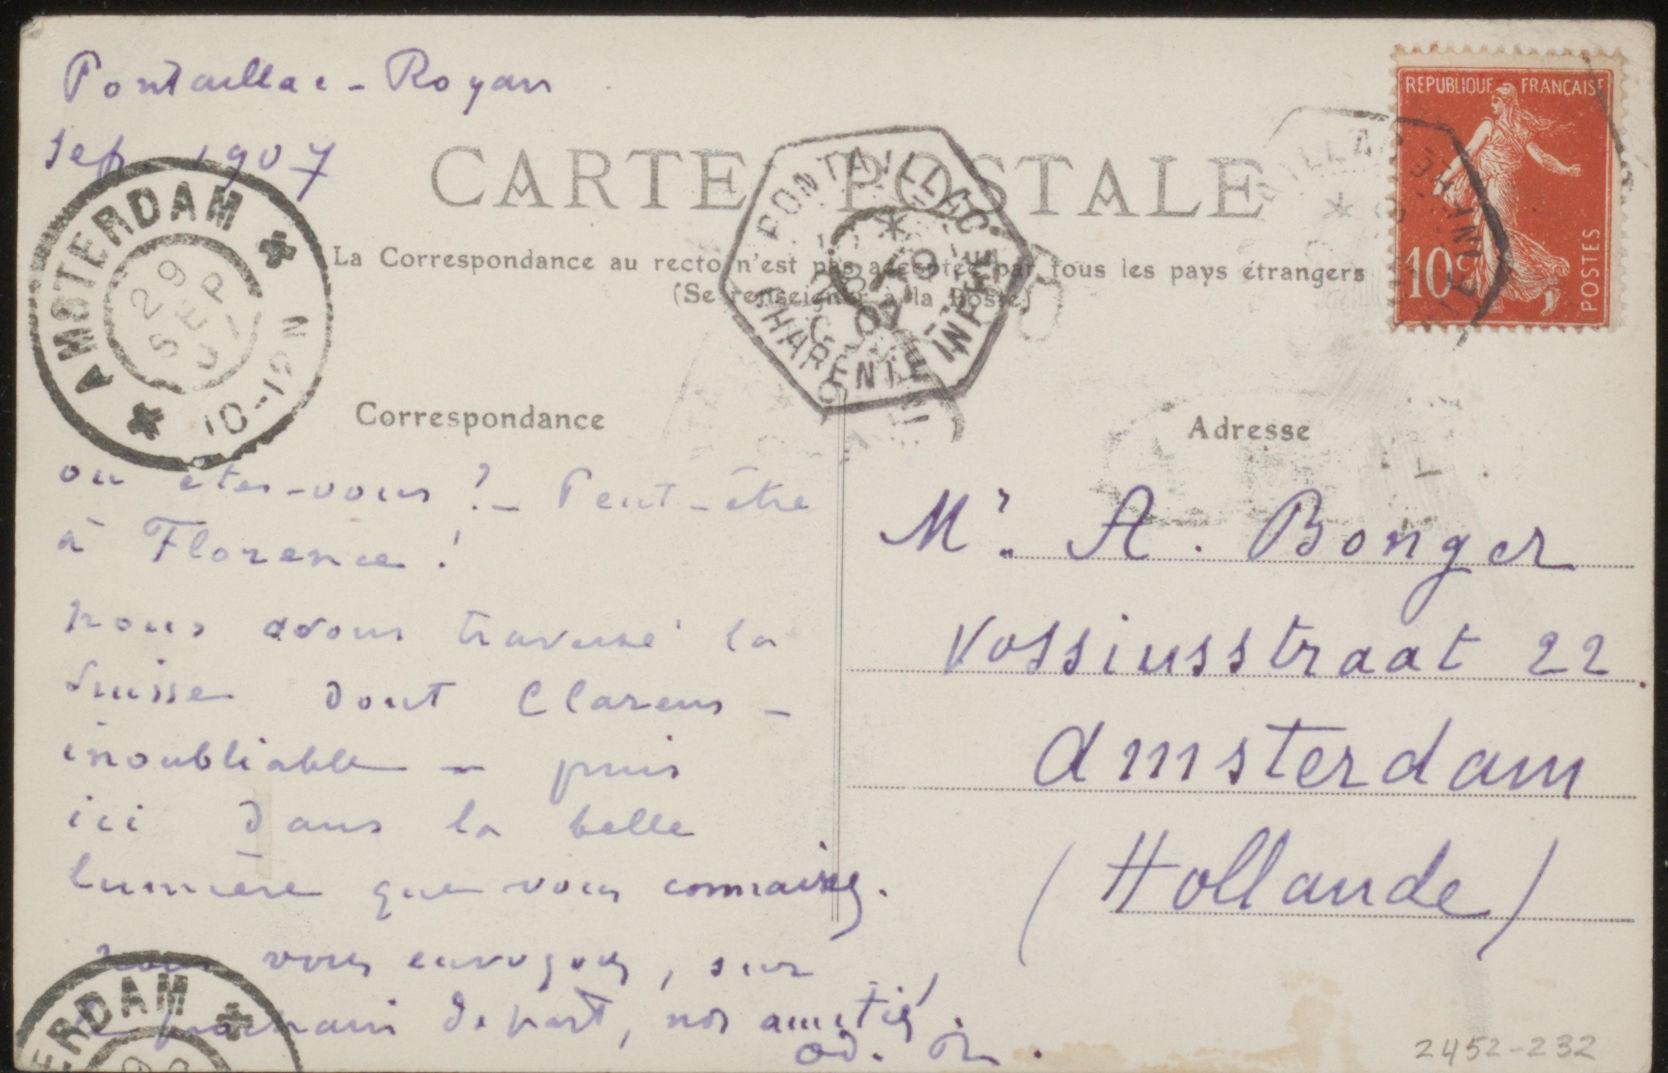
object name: ansichtkaart, prentbriefkaart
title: Prentbriefkaart aan Andries Bonger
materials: cardboard, ink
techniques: photograph, pen, writing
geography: pontaillac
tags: amsterdam, andries bonger, travelling; tourism, rotterdam, switzerland